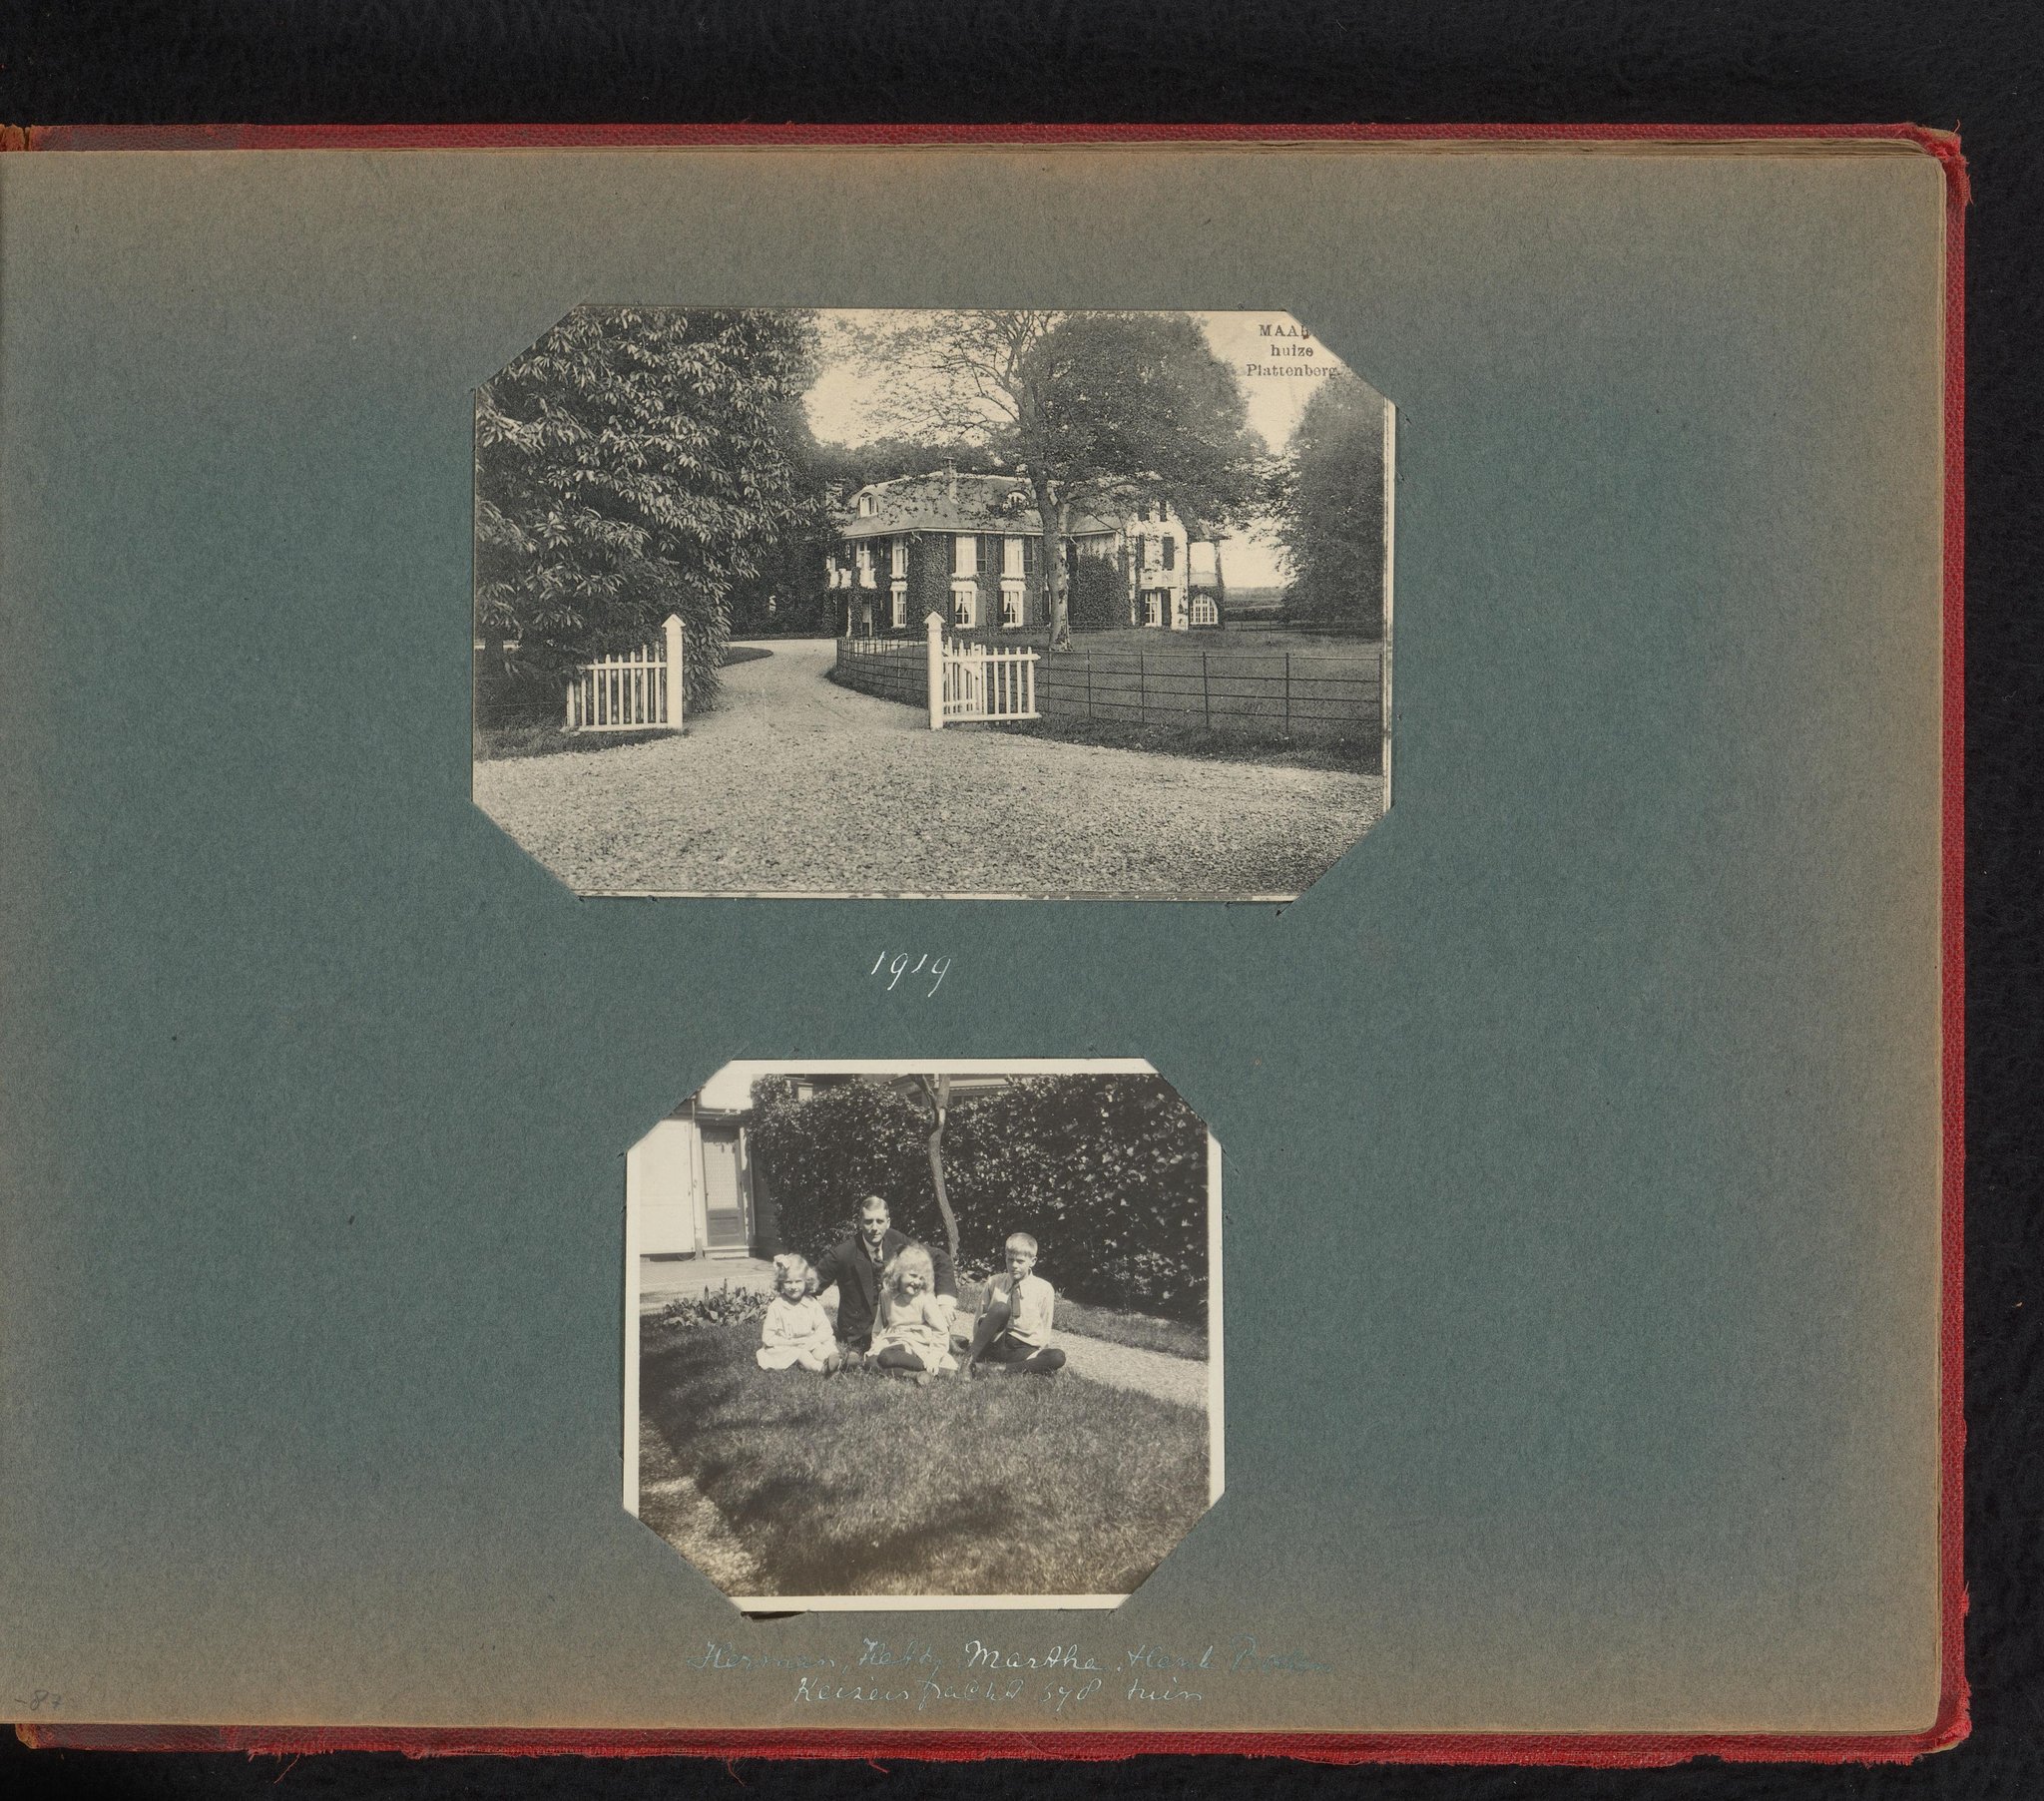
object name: photomechanical print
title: Gezicht op het landgoed Plattenberg in Maarn, en de kinderen van Co Boelen met hun oom Herman Boelen in de tuin van Keizersgracht 678 in Amsterdam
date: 1919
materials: paper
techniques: photograph, gelatin silver print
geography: amsterdam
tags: amsterdam, garden, villa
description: Groot Plattenberg was eigendom van Jacob Theodorus (Co) Boelen, Keizersgracht 678 was het woonhuis van het gezin Joan Boelen.